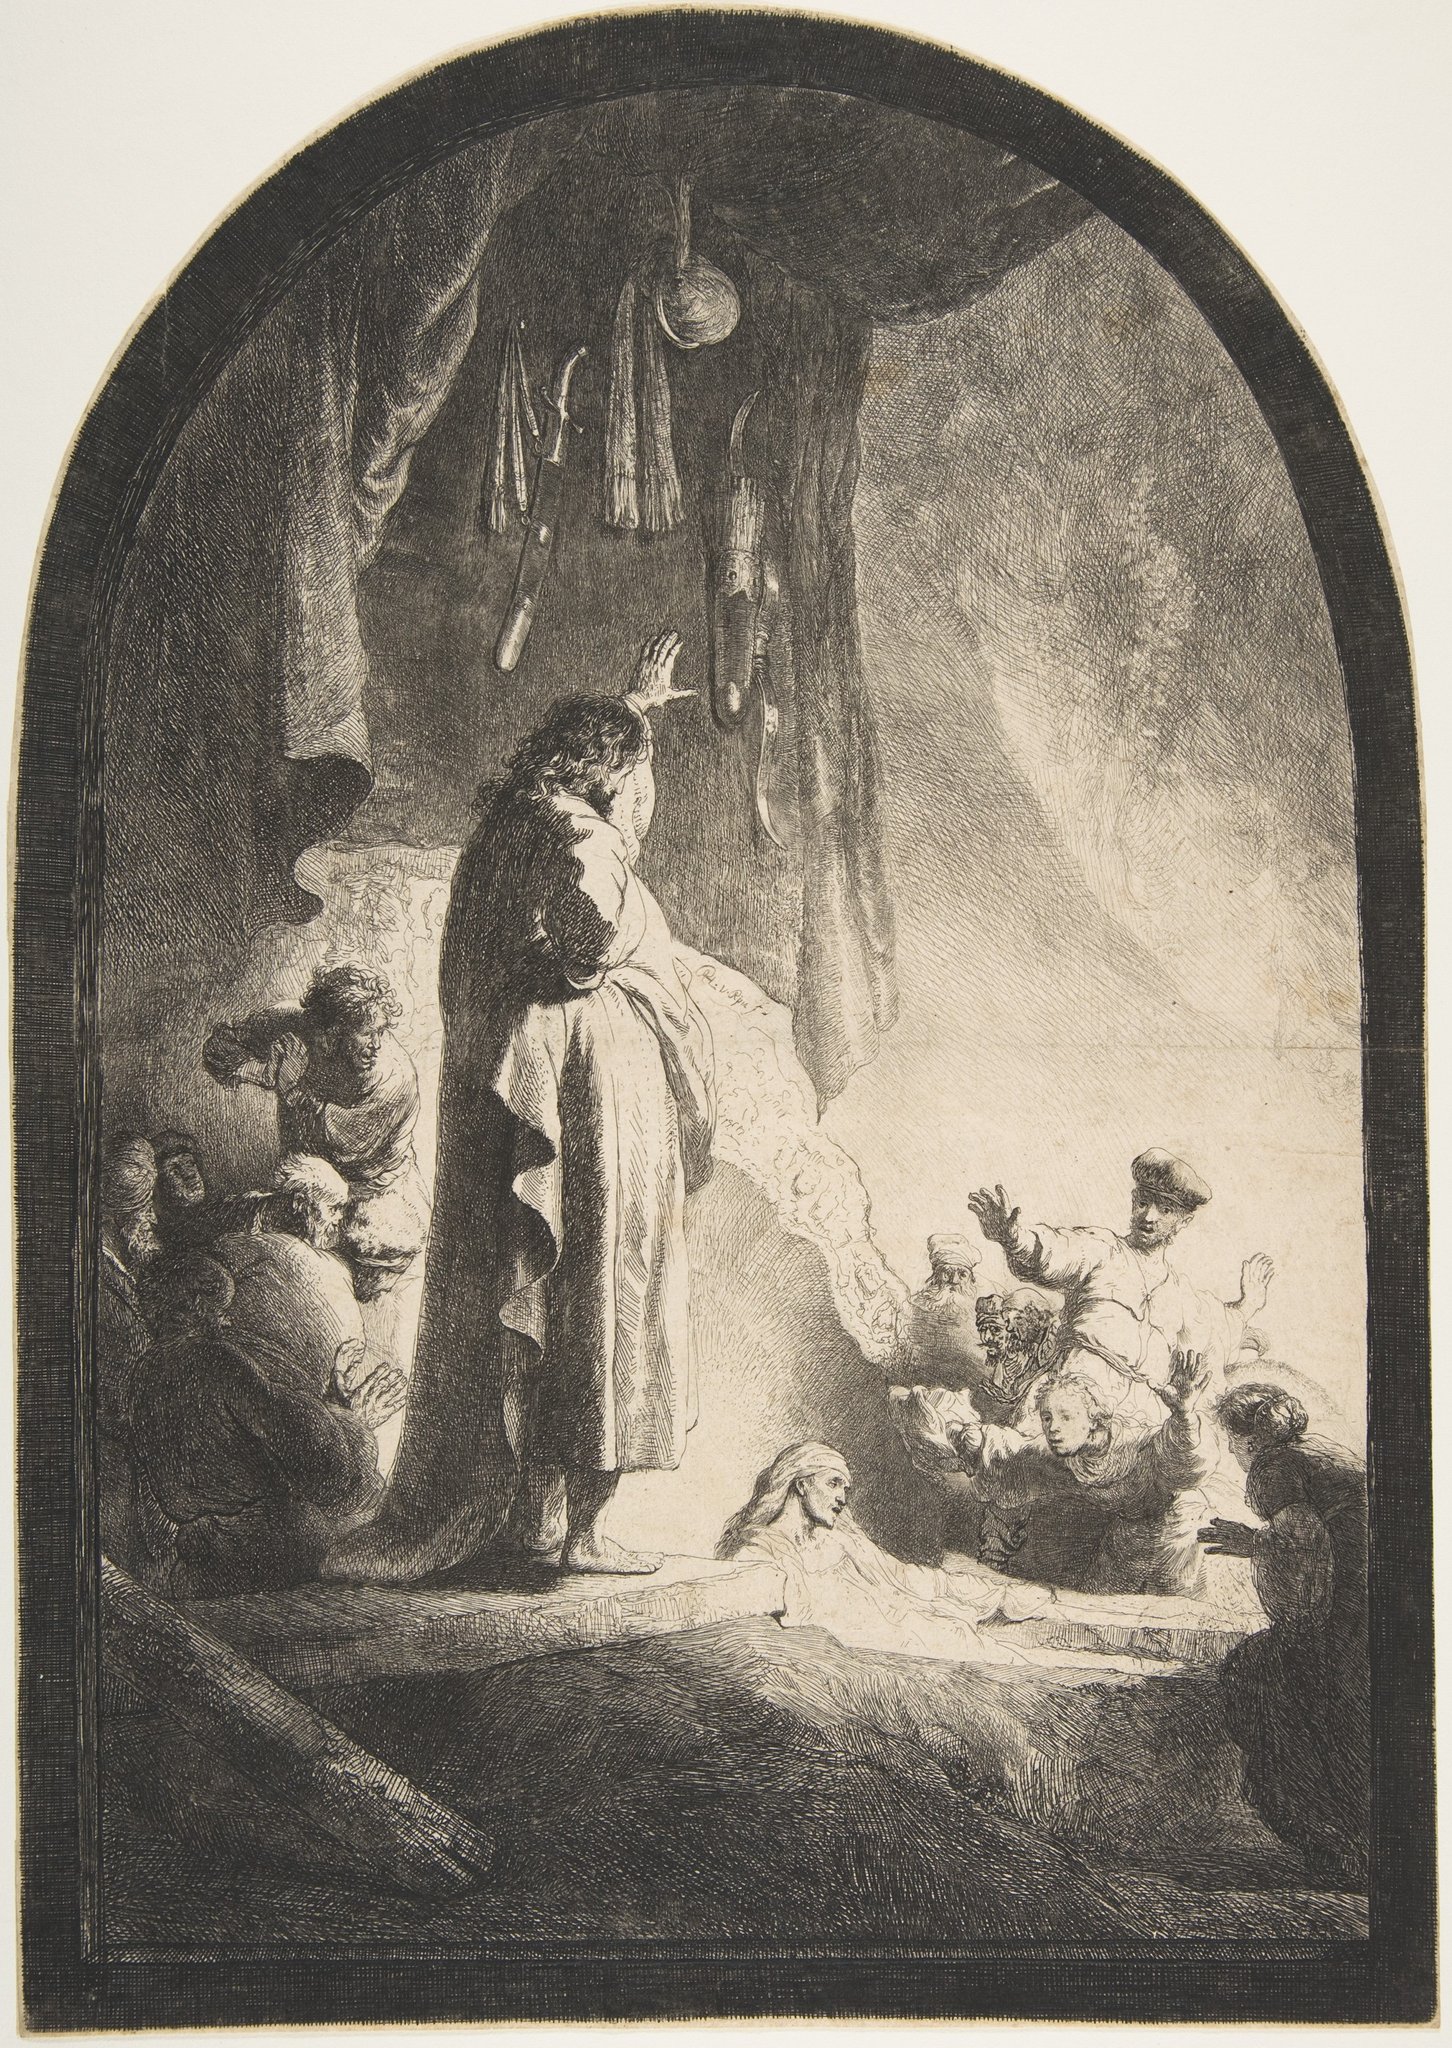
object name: print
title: The Raising of Lazarus: The Larger Plate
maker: rembrandt van rijn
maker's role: artist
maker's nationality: dutch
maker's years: 1606-1669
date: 1632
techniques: engraving, etching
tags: men,saints